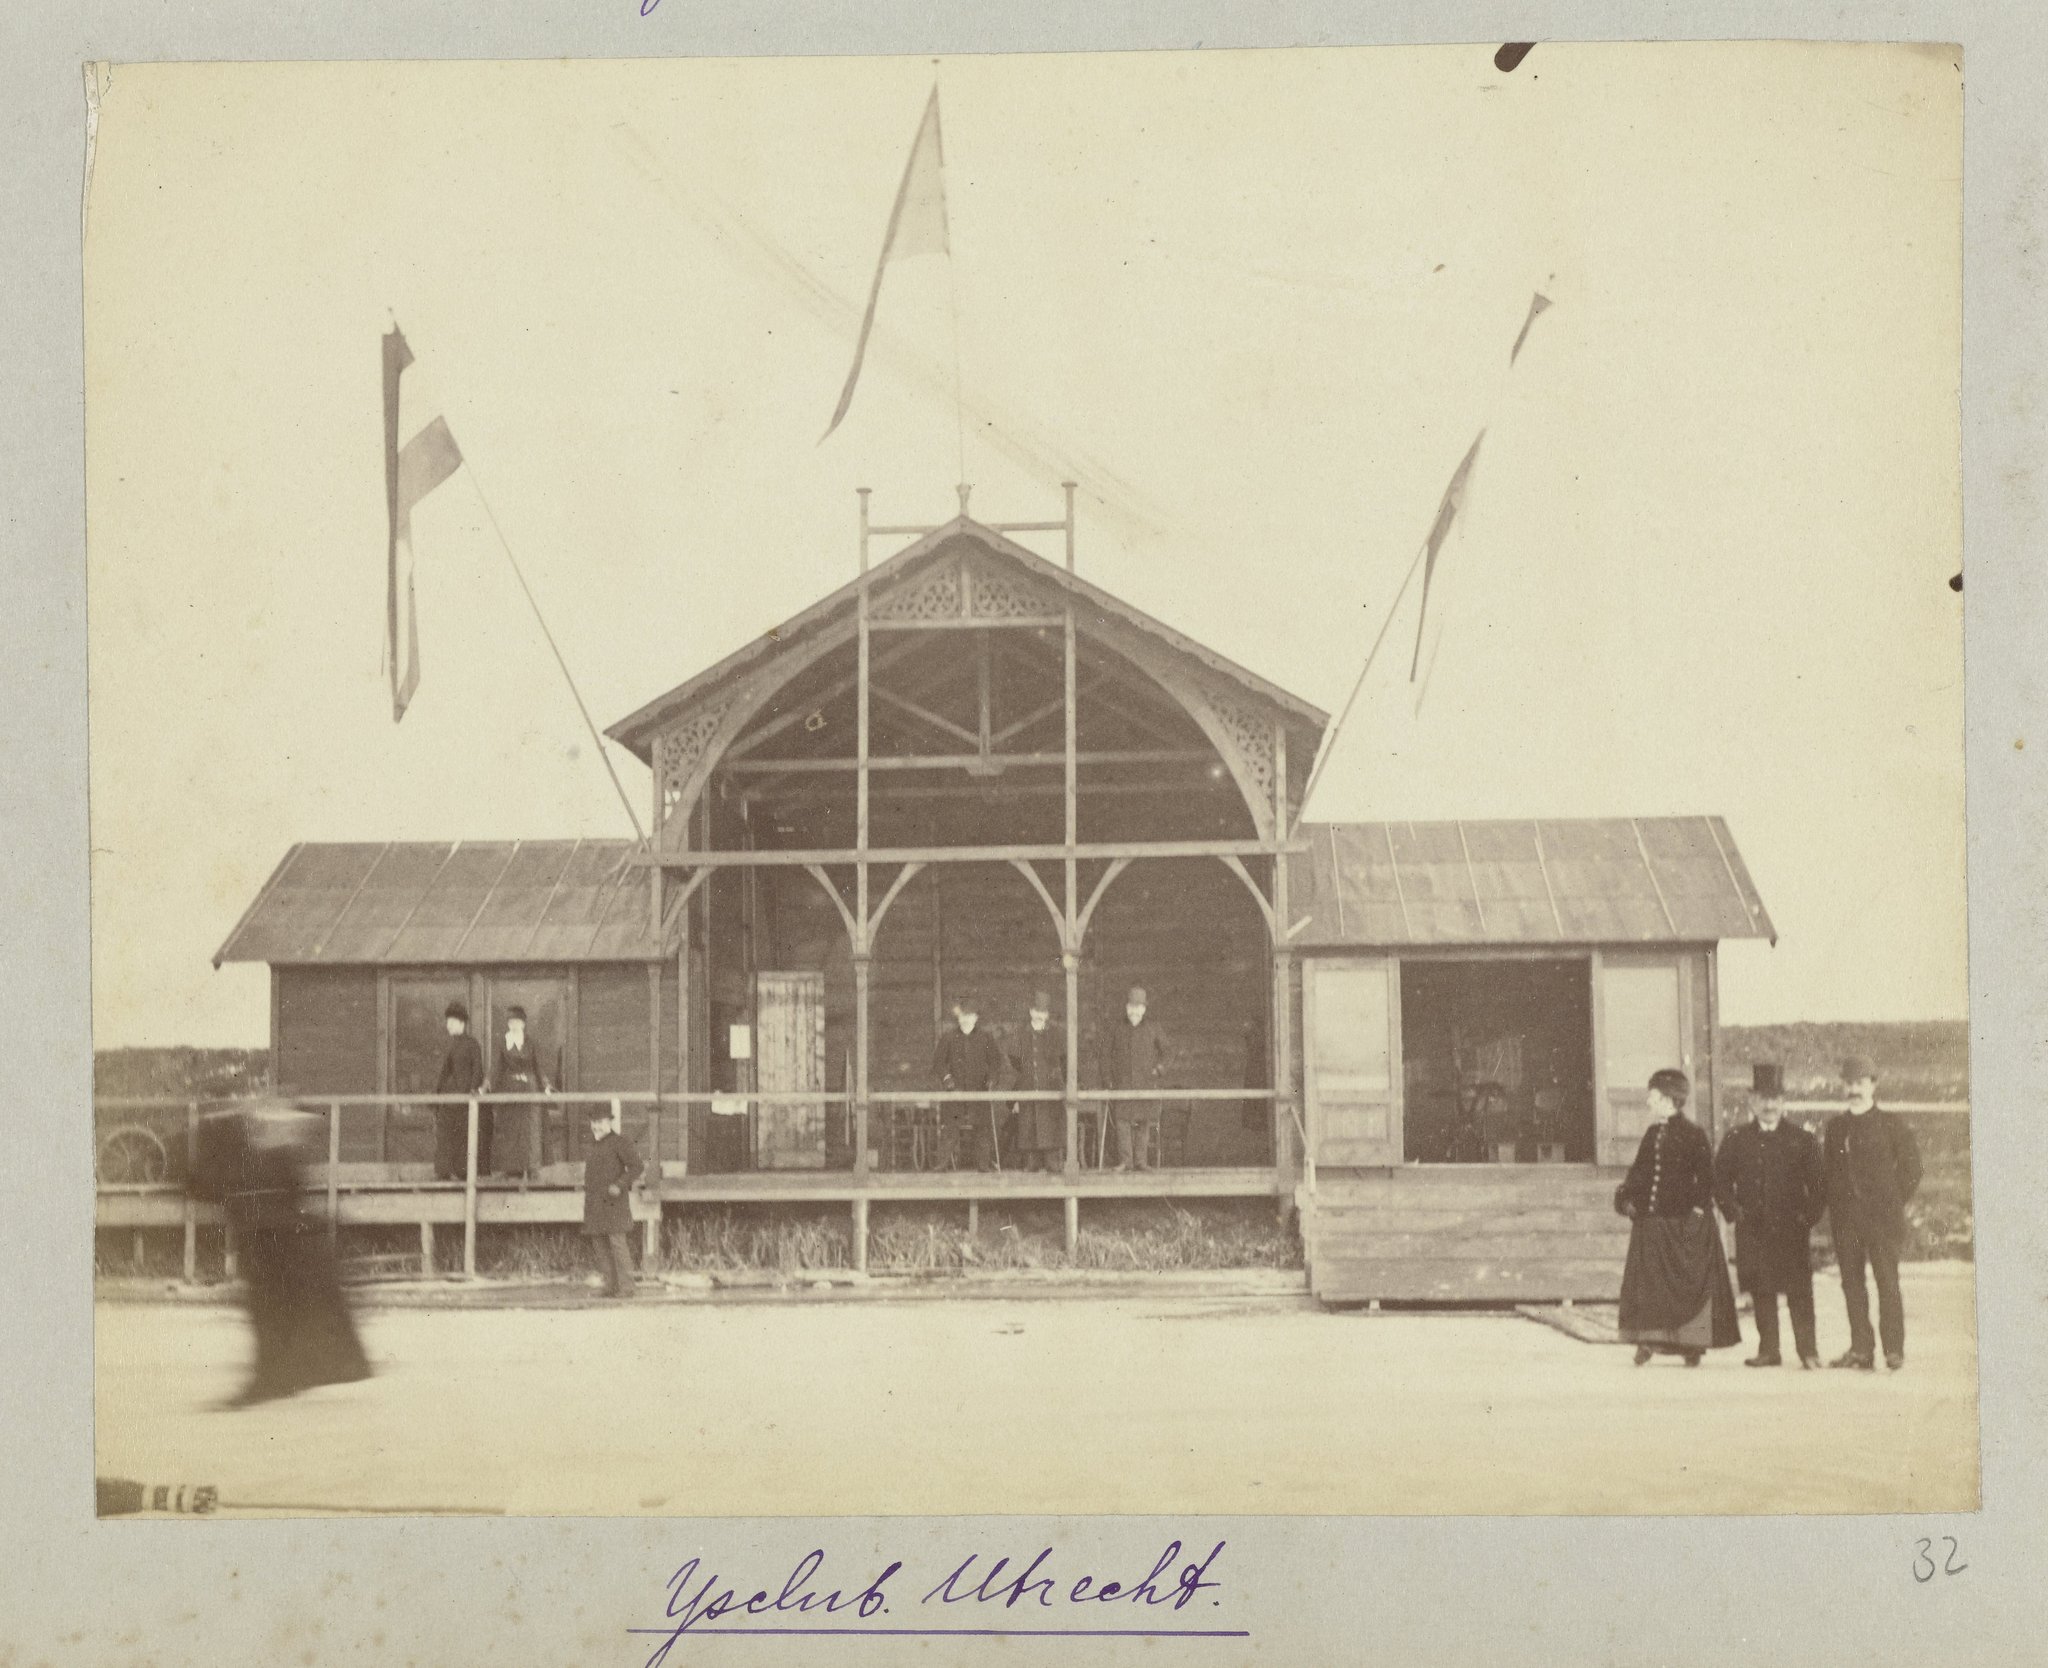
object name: photograph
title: Het clubgebouw van IJsclub Utrecht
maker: henry pauw van wieldrecht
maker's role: fotograaf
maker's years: 1863-1912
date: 1888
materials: paper, photographic support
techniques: albumen print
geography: netherlands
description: Het clubgebouw van IJsclub Utrecht met wapperende vlag. Voor het gebouw staat een aantal mannen met bolhoed en lange overjas. Met onderschrift: IJsclub Utrecht.